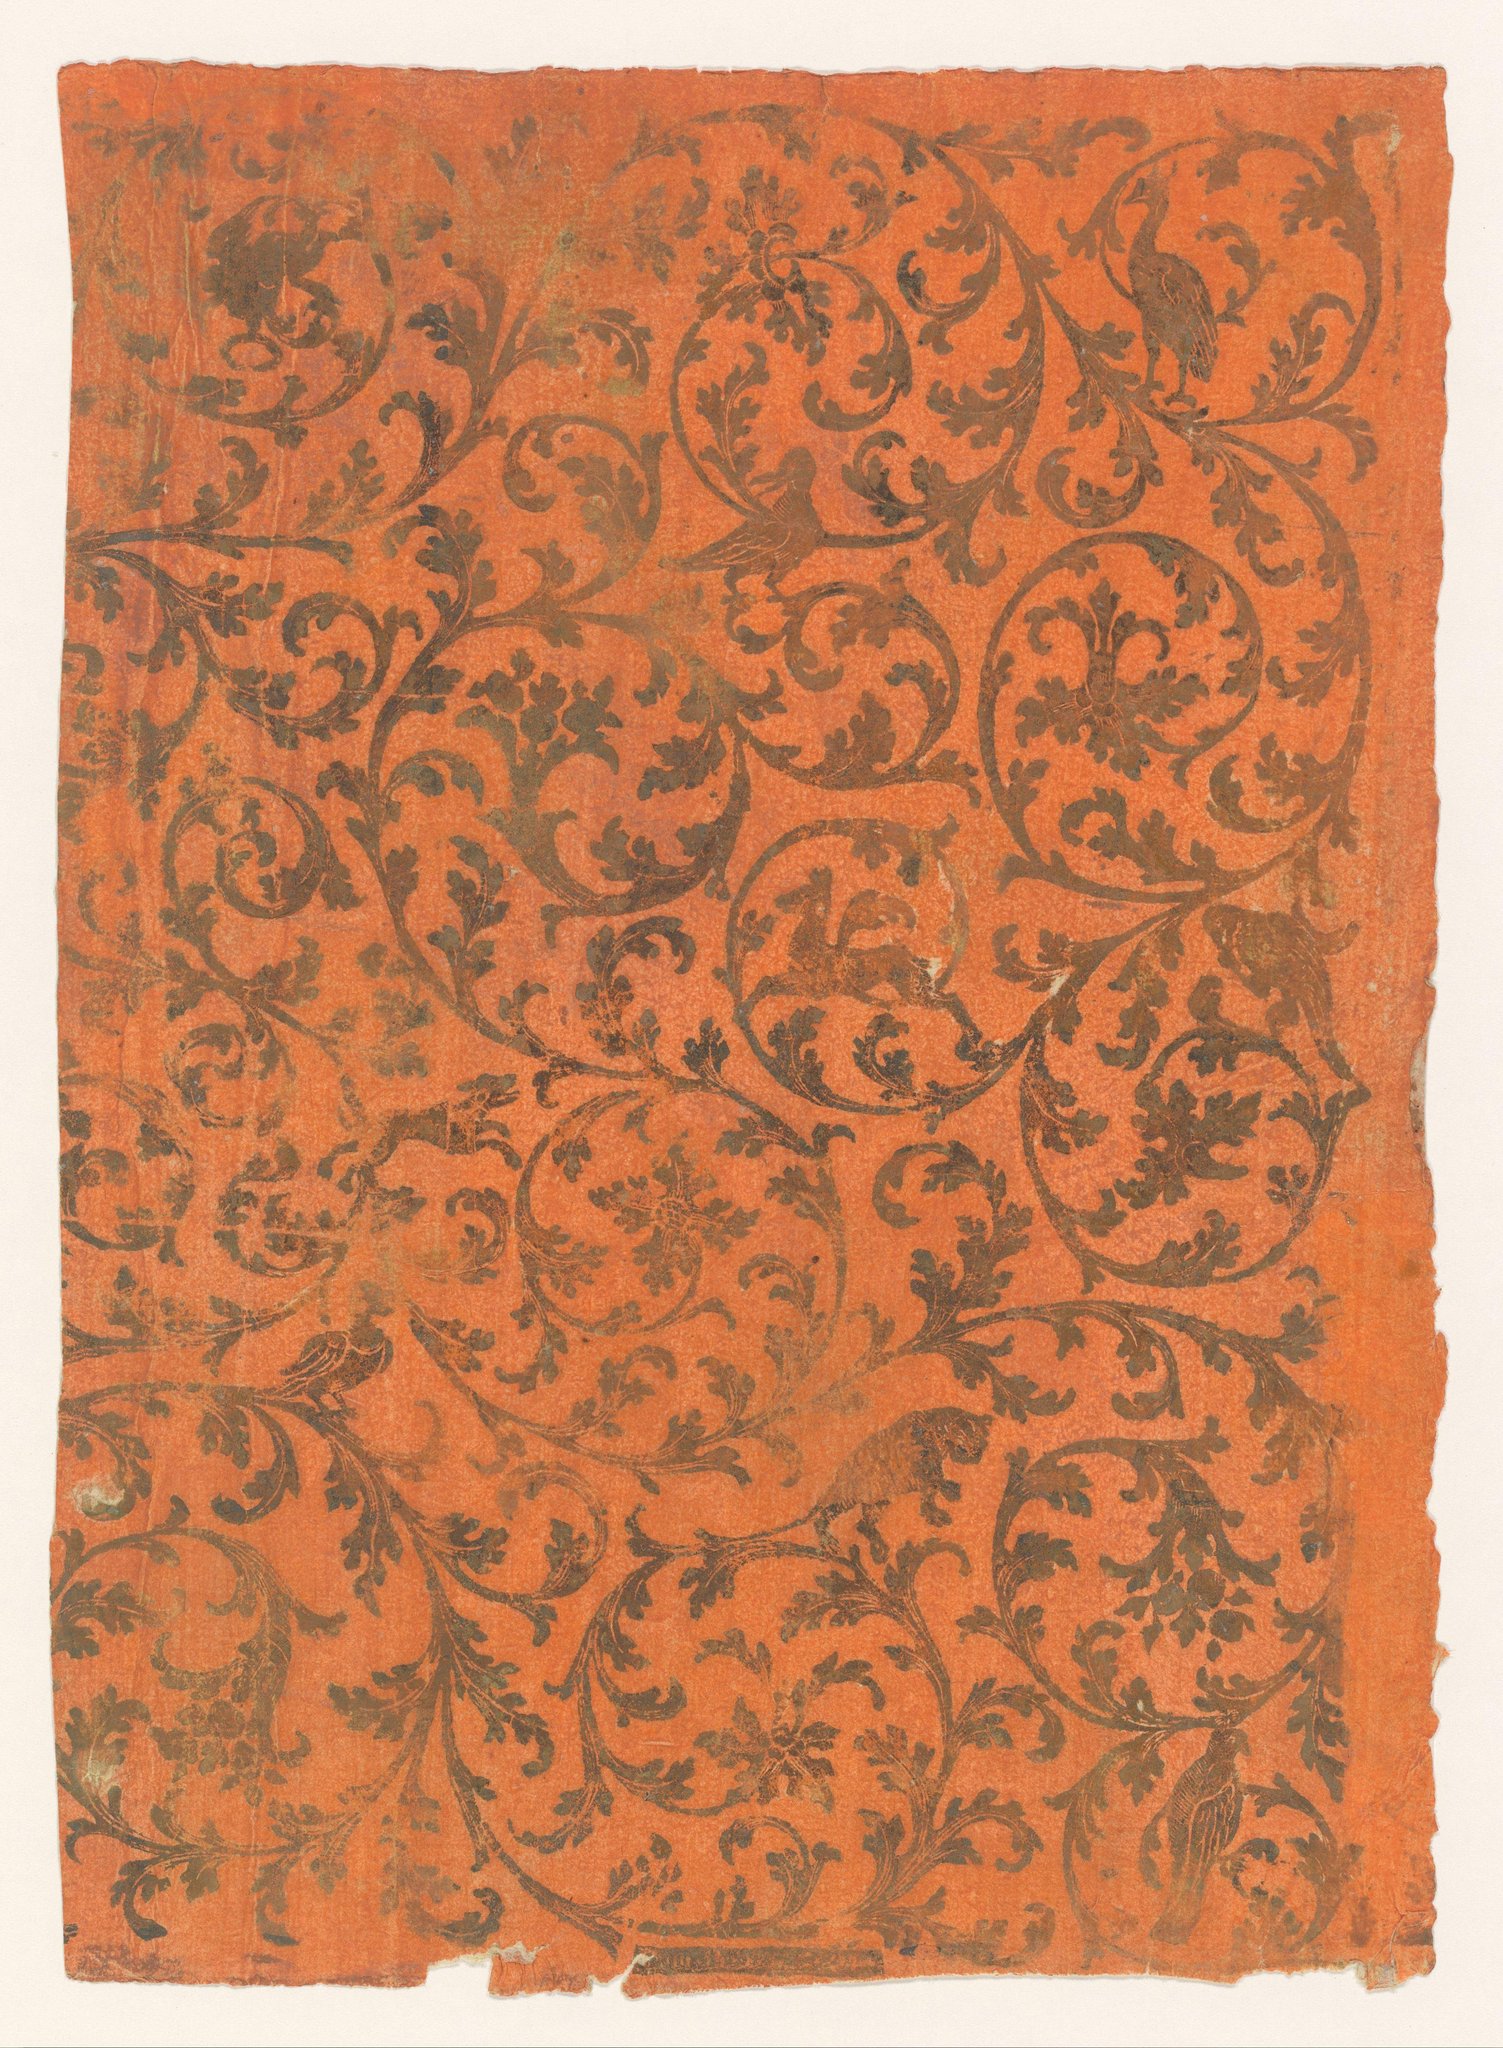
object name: brocade paper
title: Blad mt ranken met bloemen met dieren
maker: Anonymous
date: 1700-1750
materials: gold leaf, paint, paper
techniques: relief print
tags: ornament derived from animal forms, hoofed animals: deer, ornament derived from plant forms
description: Ranken met bloemen met dieren, in het bladmidden een naar links springend hert, rechtsonder papegaai.